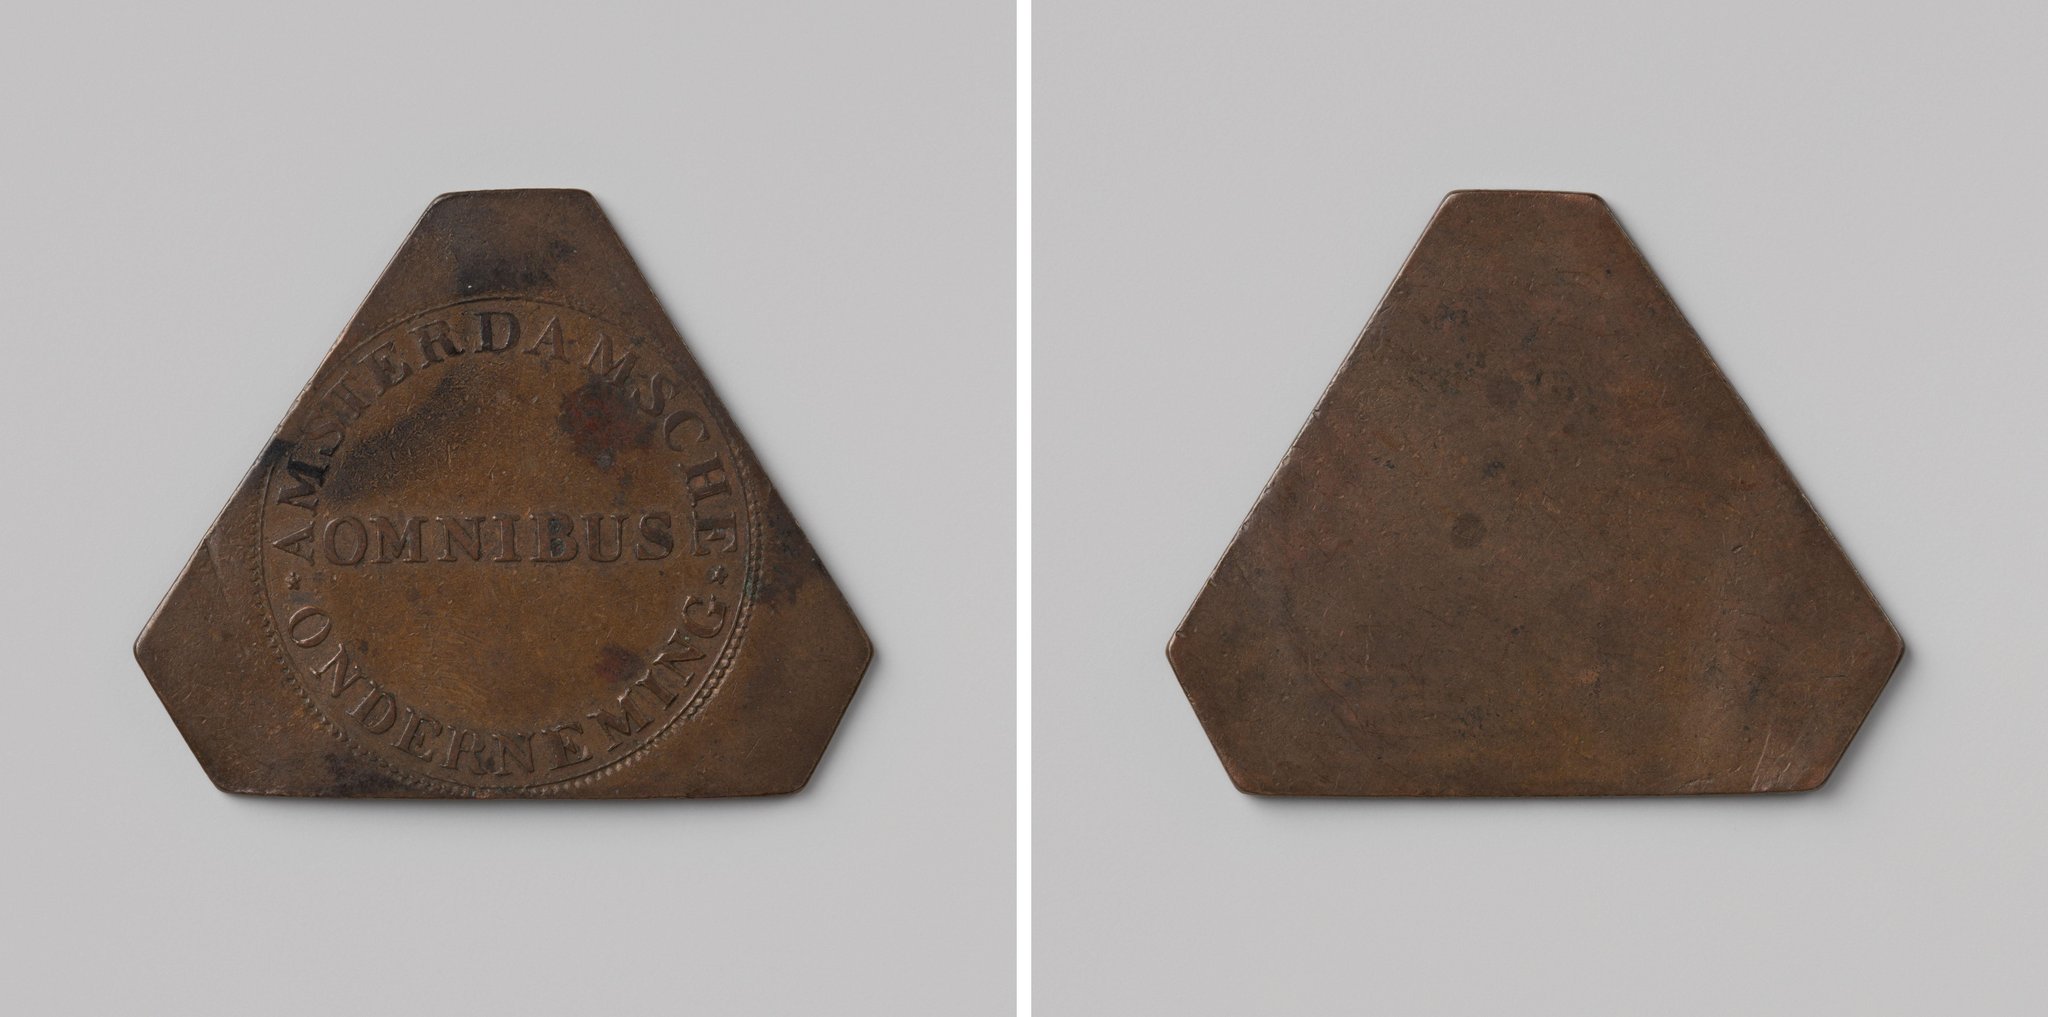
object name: identification medal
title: Amsterdamsche Omnibus Onderneming, penning van een controleur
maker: Anonymous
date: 1839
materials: copper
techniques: striking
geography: amsterdam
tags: amsterdam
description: Eenzijdige koperen driehoekige penning met afgeschuinde hoeken. Voorzijde: in parelcirkel: opschrift binnen omschrift. Keerzijde: blanco.